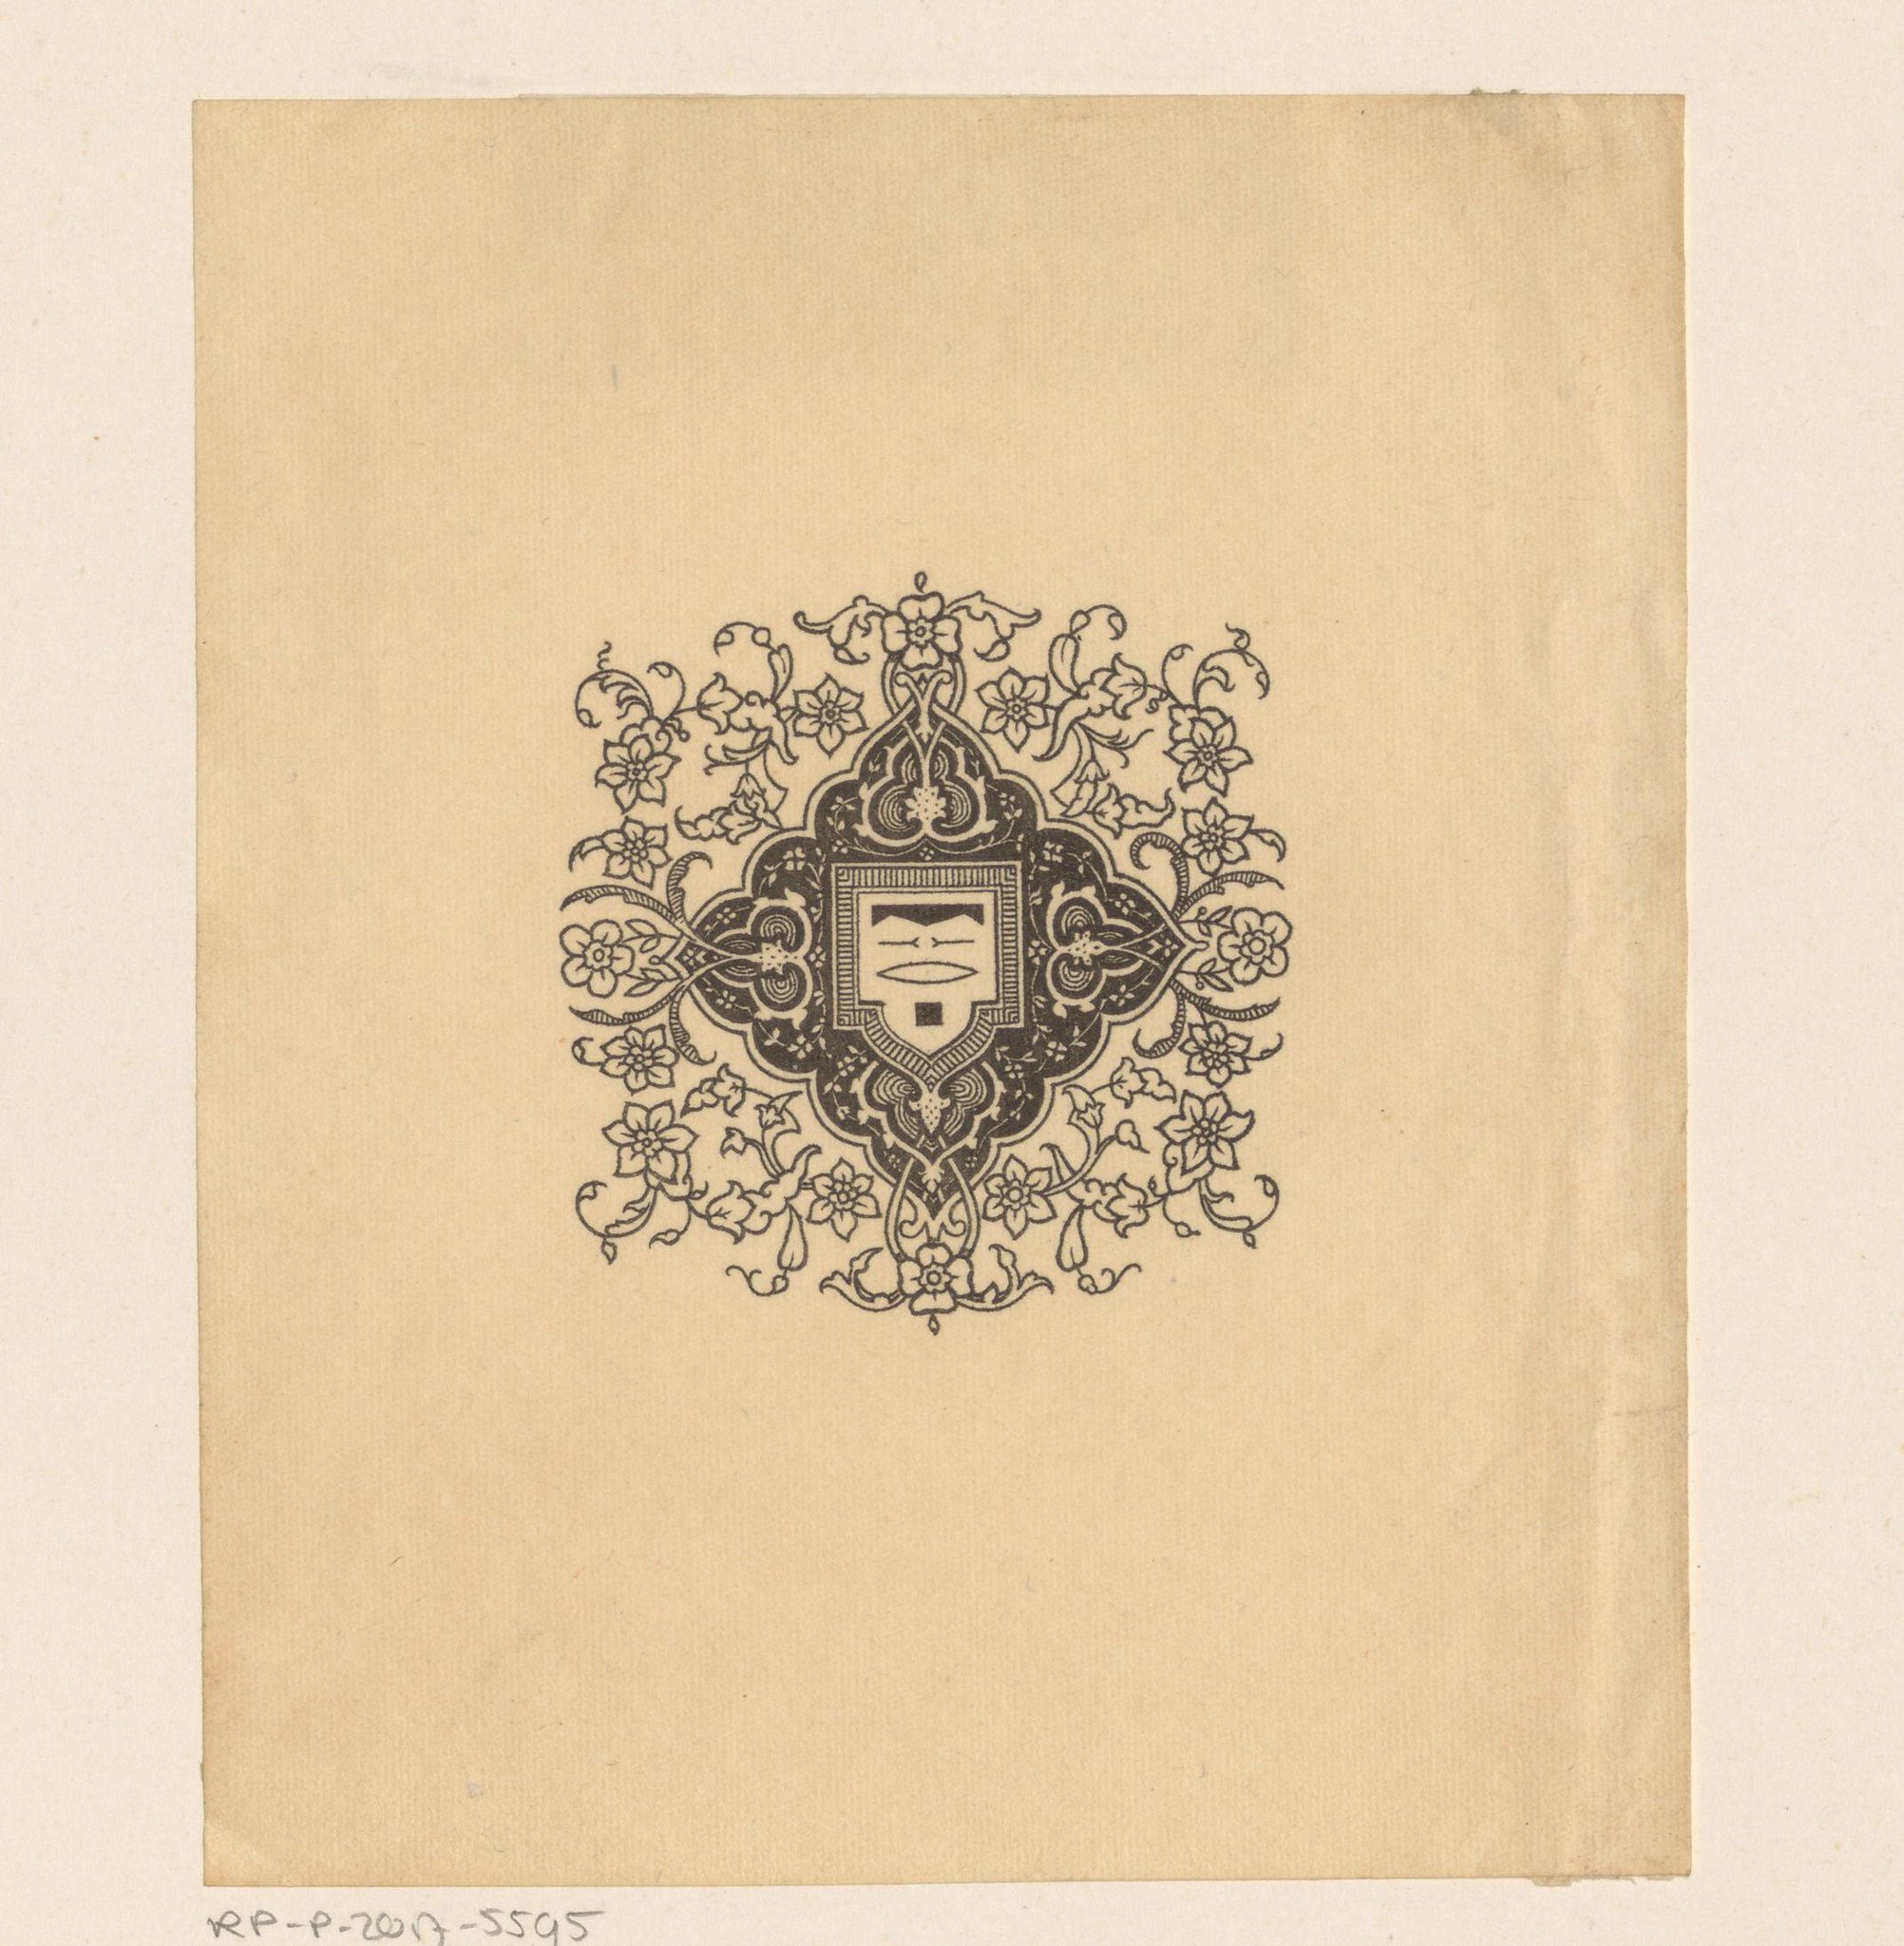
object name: bookplate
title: Ex libris van onbekend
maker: Anonymous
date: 1850-1924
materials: paper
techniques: printing block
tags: floral interlace ~ ornament